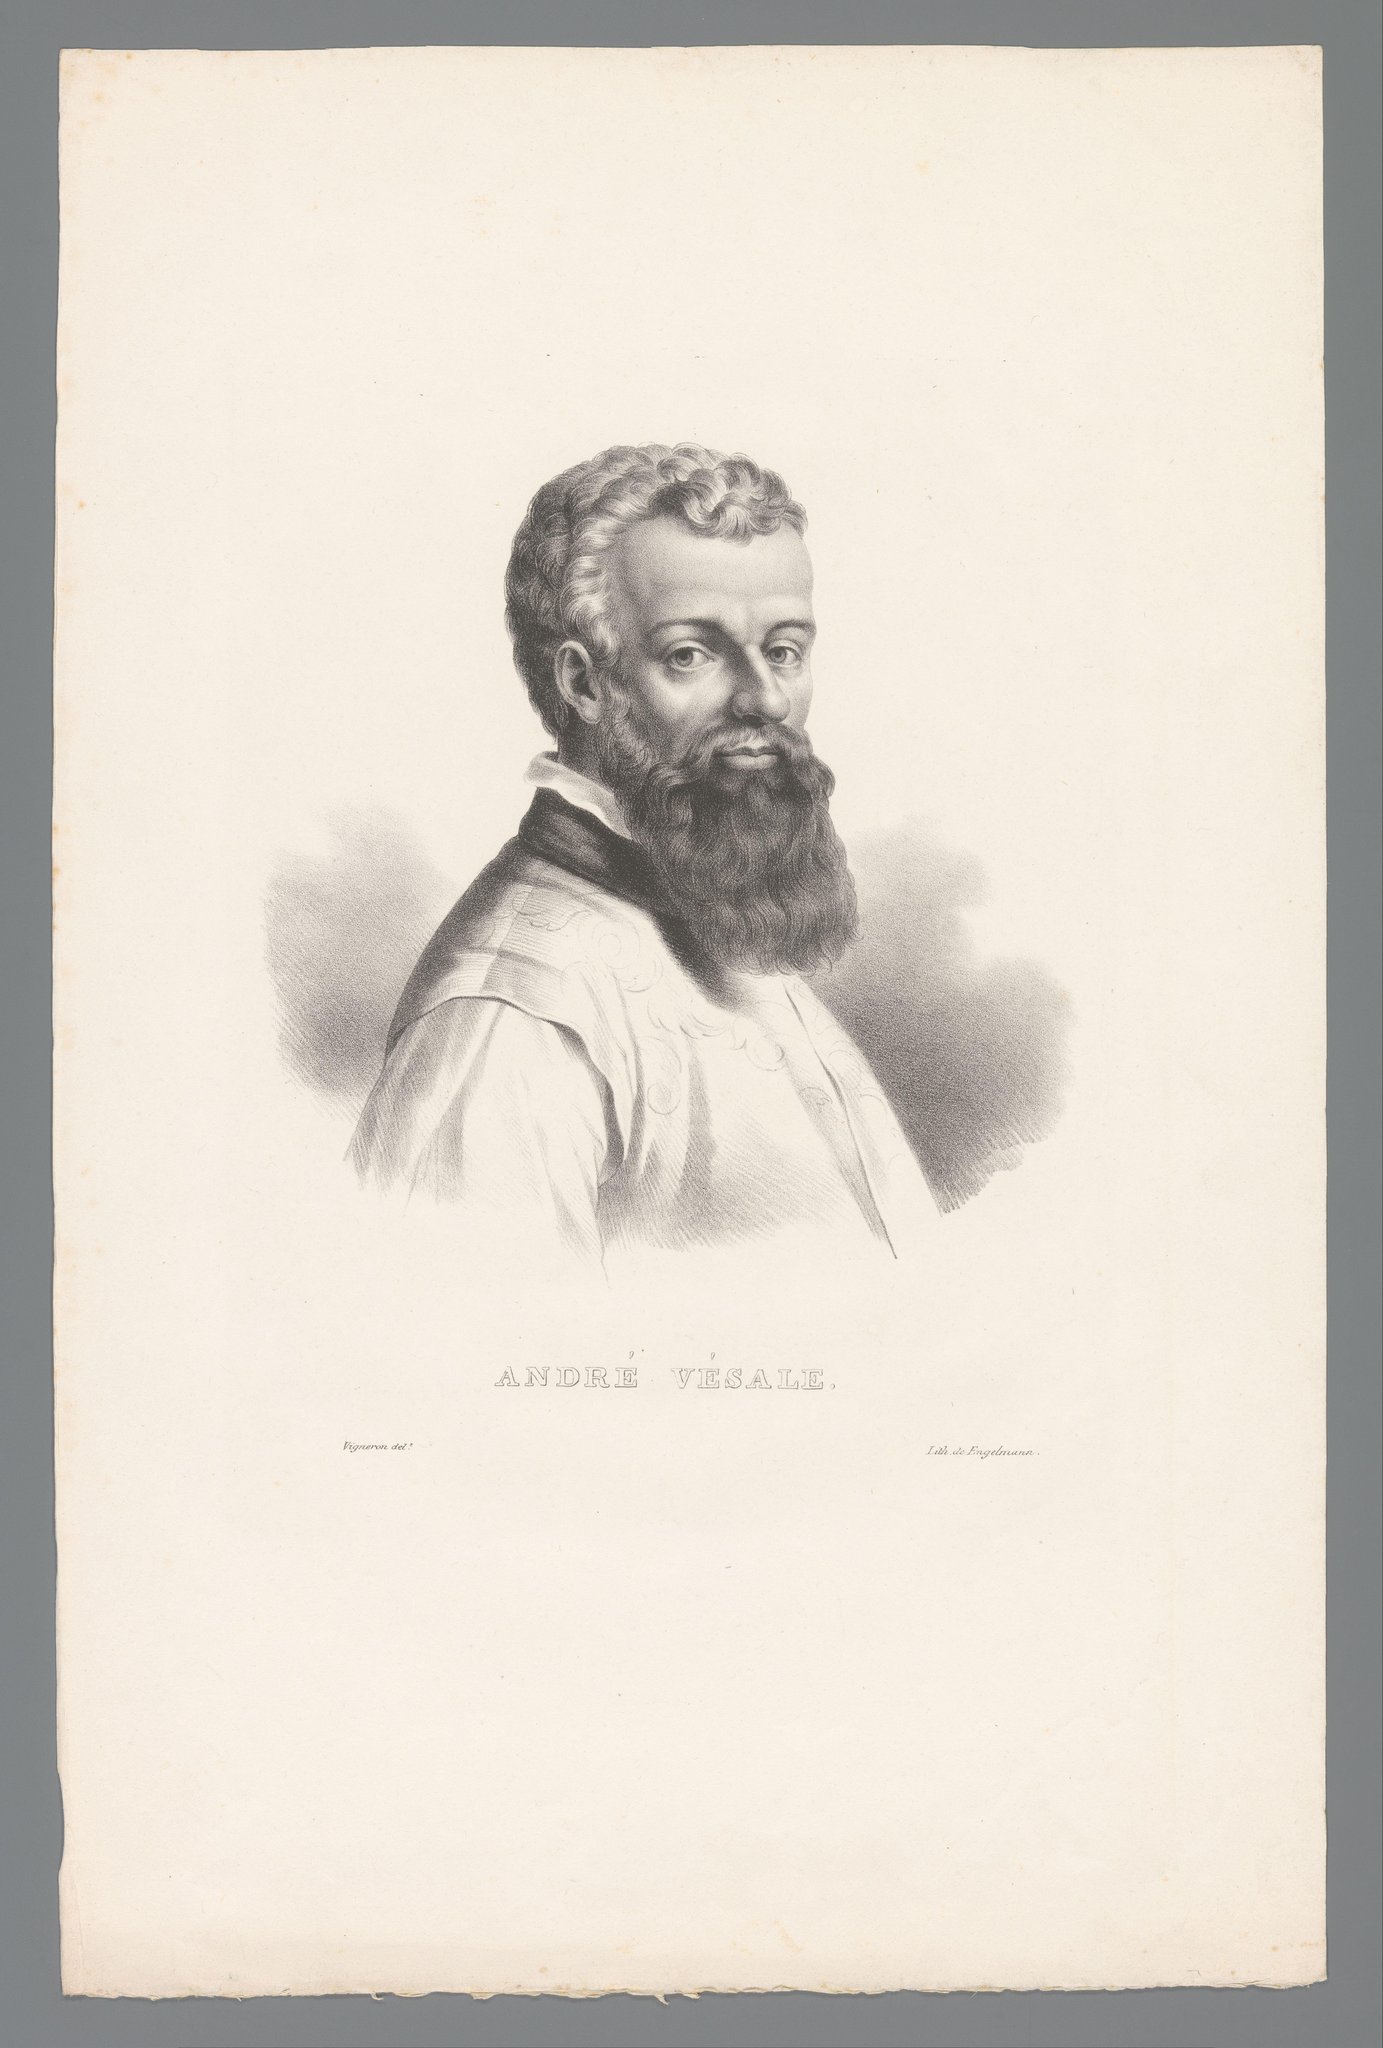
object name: print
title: André Vésale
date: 1816-1833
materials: paper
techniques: lithograph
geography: paris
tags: historical persons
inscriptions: collector's mark: Lugt 2228